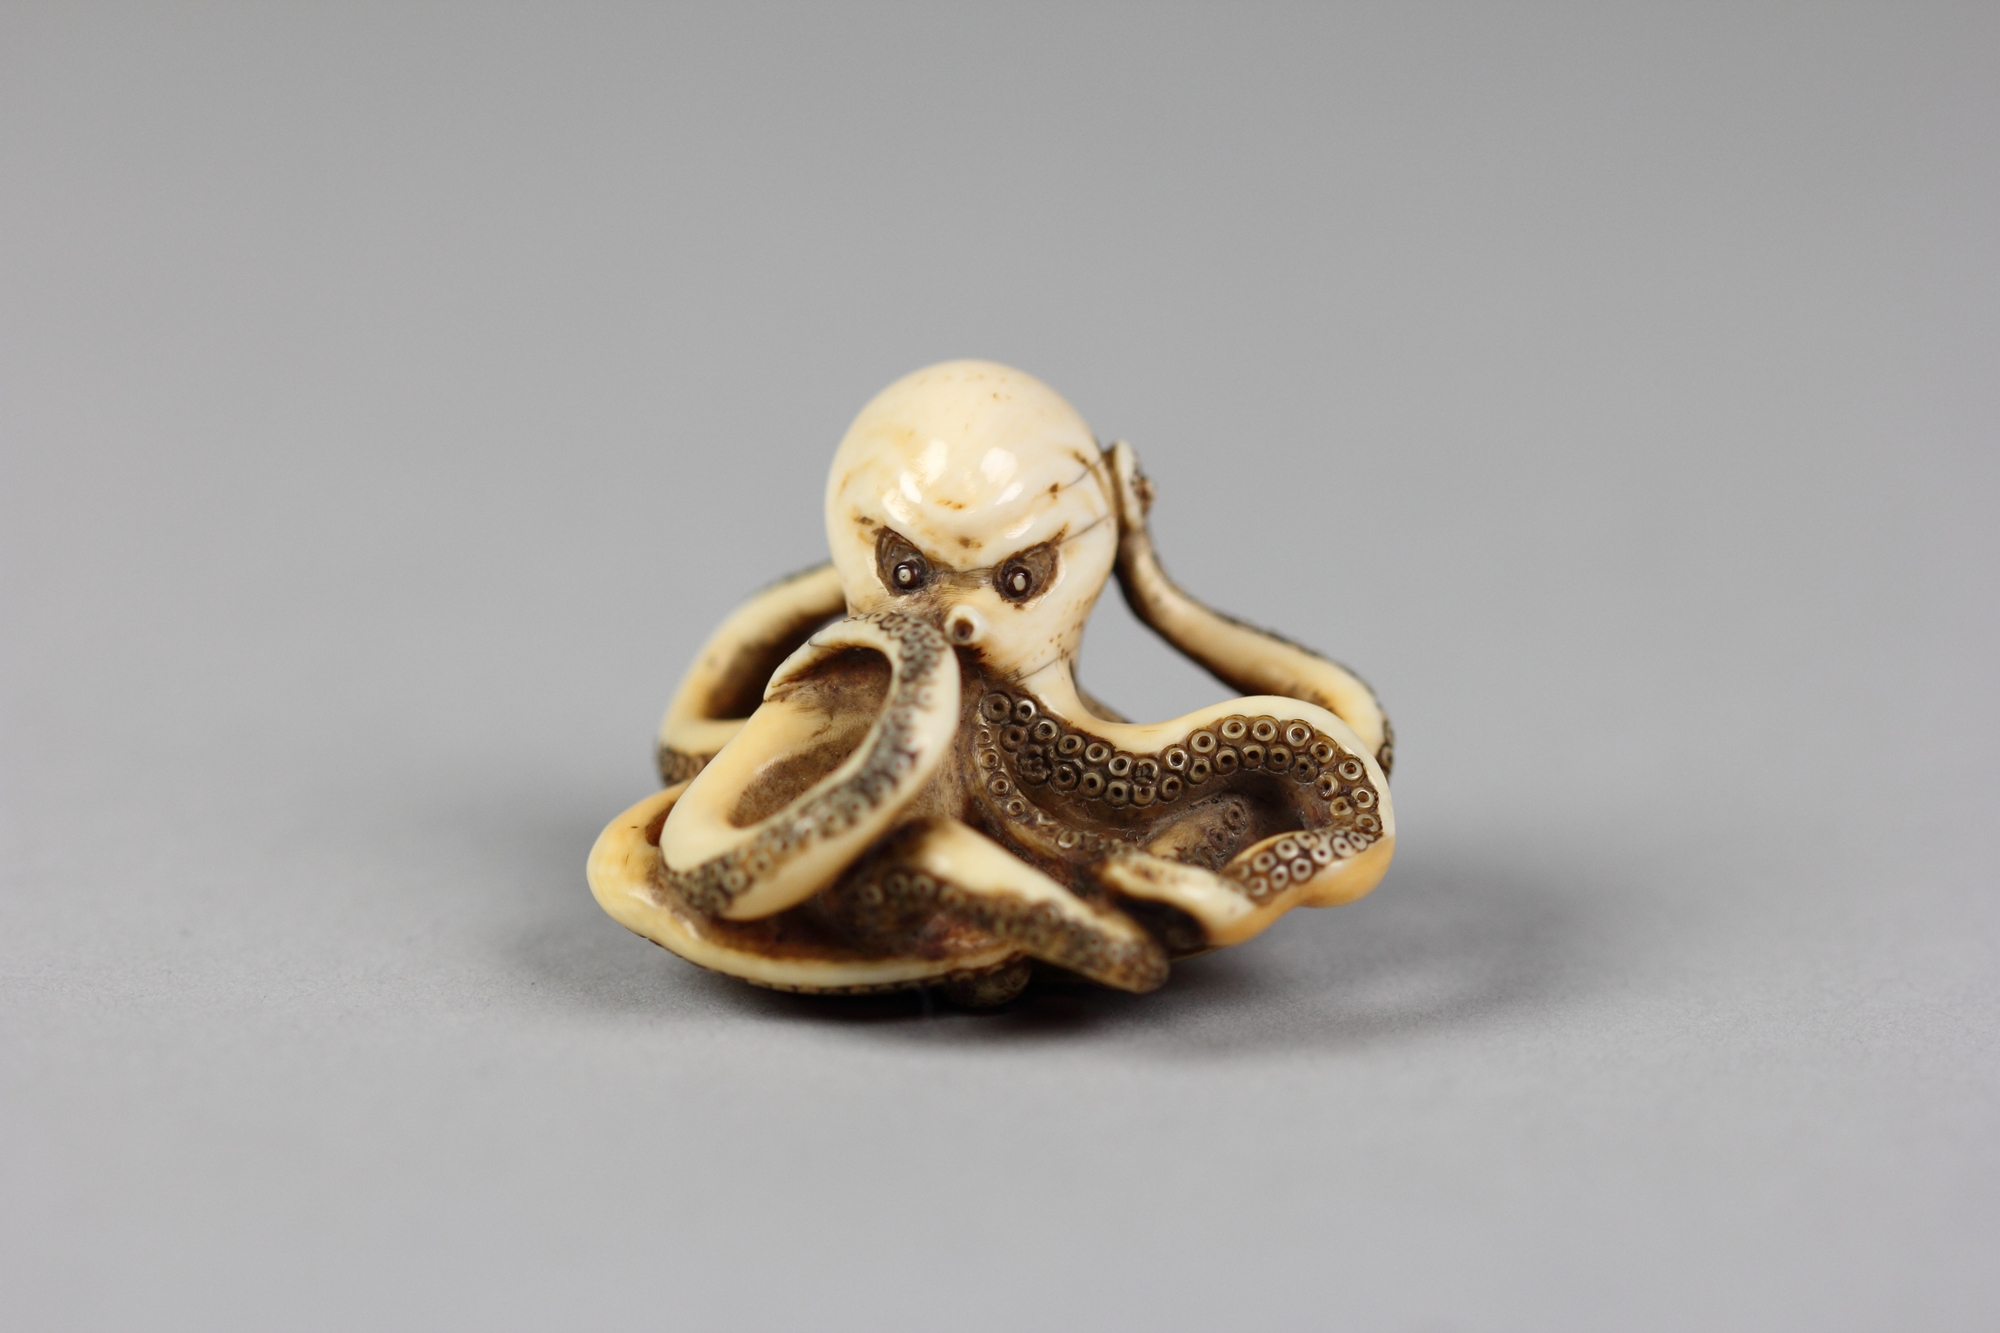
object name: netsuke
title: Netsuke of Octopus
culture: japanese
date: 1801-1900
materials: ivory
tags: octopus